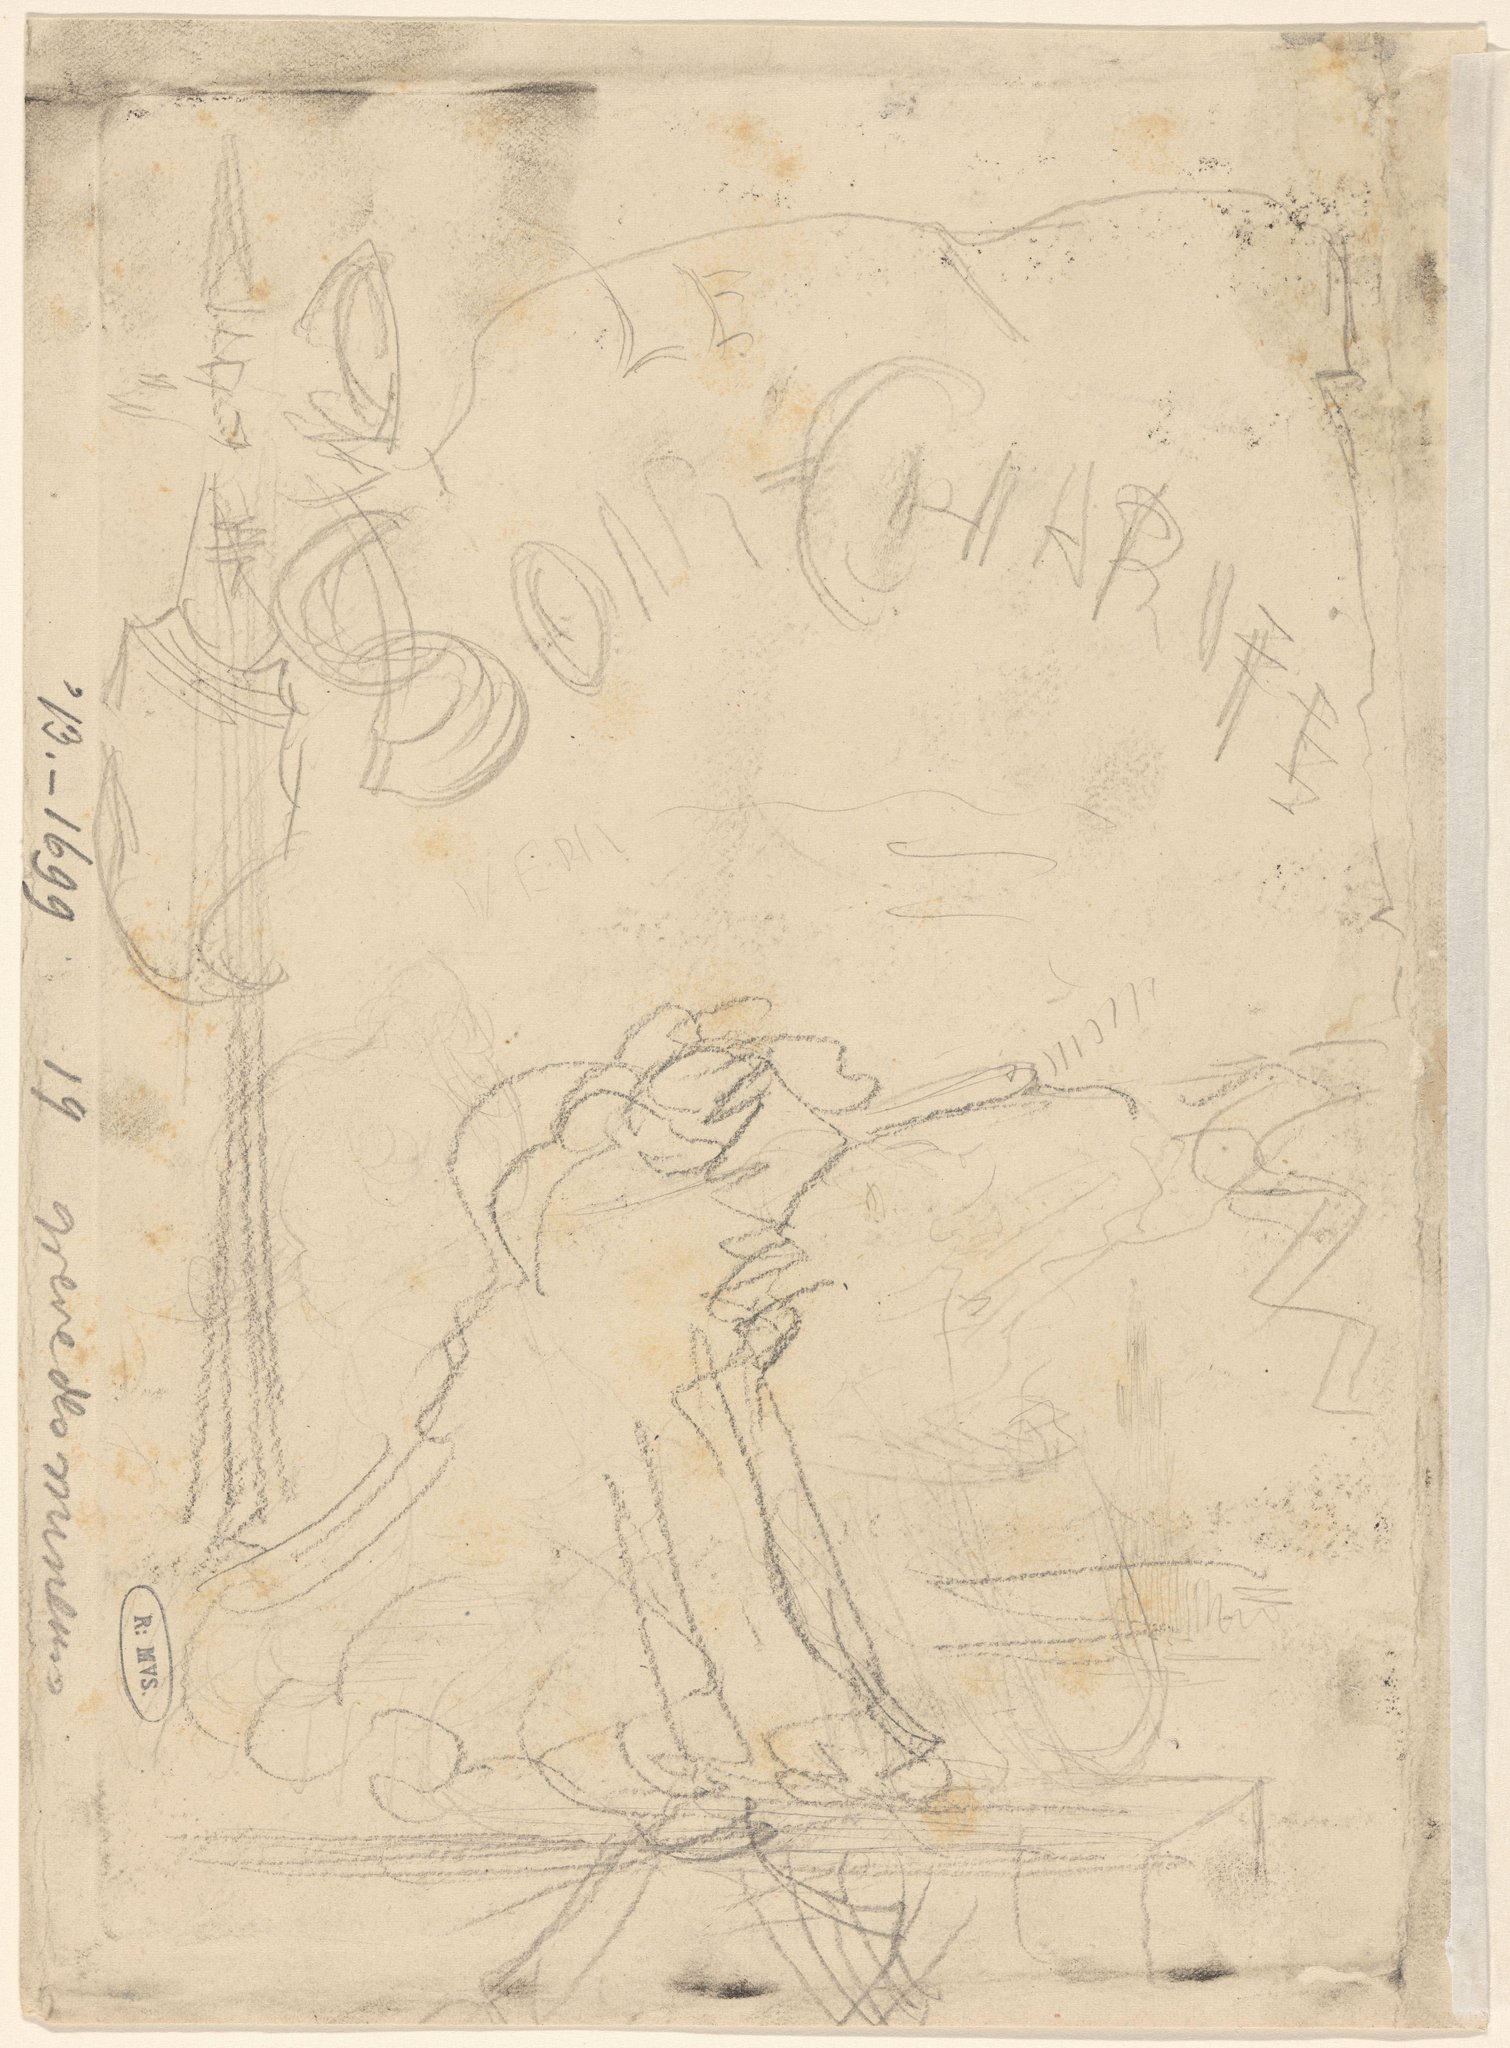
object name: print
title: Vaandel en figuur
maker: karl meunier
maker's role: print maker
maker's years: 1864-1894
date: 1889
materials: paper, pencil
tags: banner, standard (as symbol of the state, etc.)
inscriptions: collector's mark: Lugt 2228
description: Schets met bovenaan de tekst: 'Le Soir Charite'.